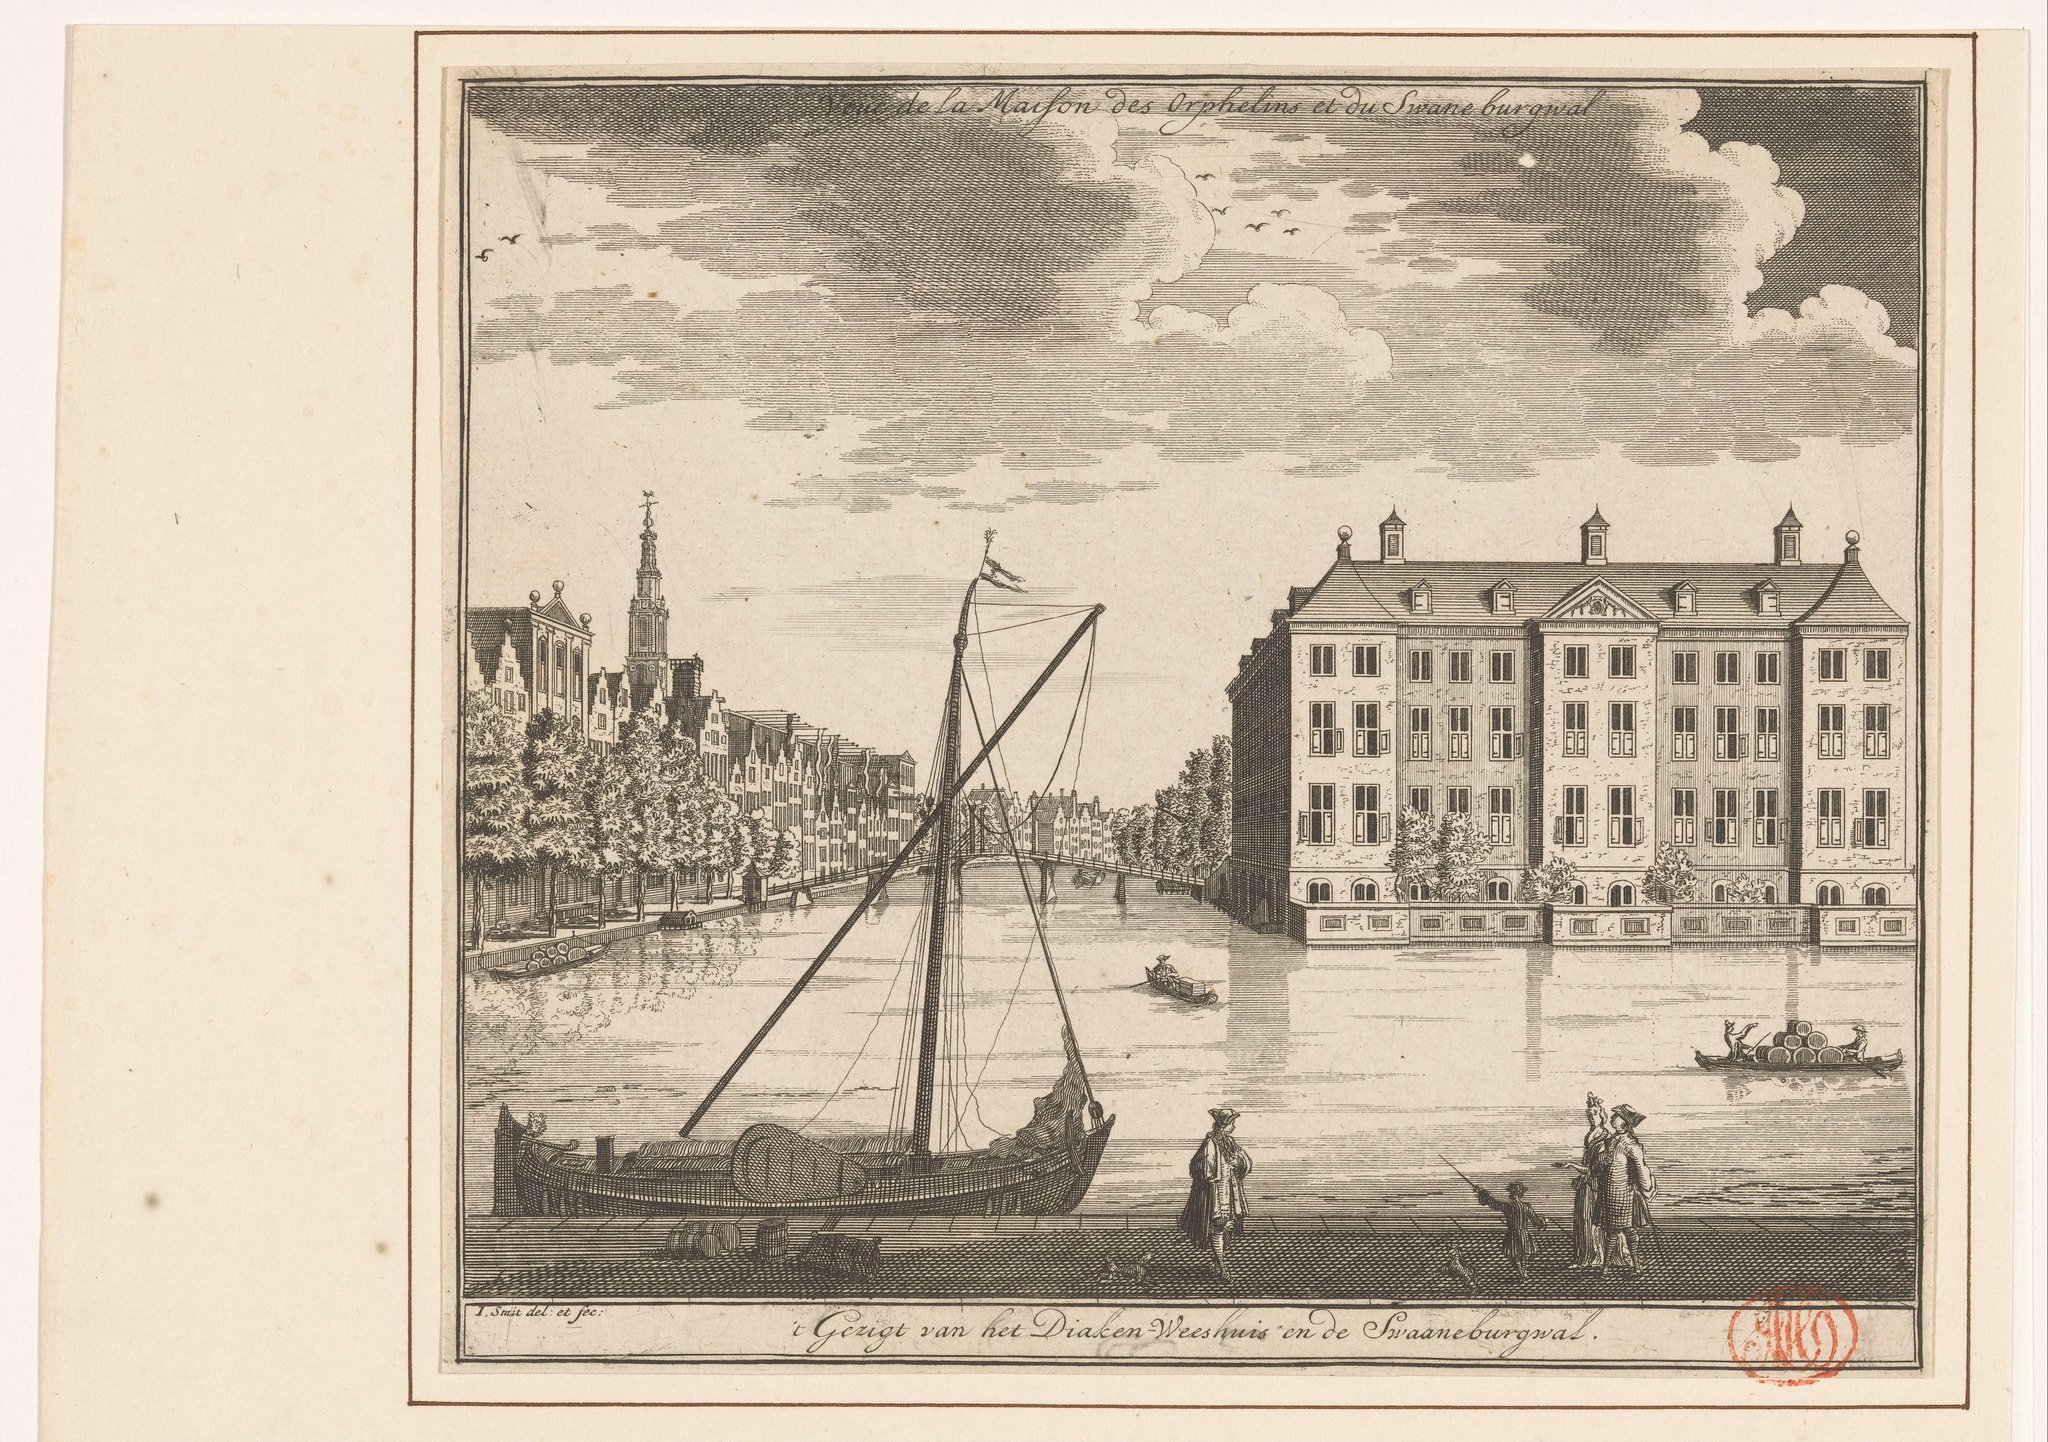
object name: print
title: Veüe de la Maison des Orphelins et du Swane burgwal / 't Gezigt van het Diaken-Weeshuis en de Swaaneburgwal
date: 1700-1748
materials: paper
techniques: engraving, etching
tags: bridge in city across river, canal, etc. (+ city(-scape) with figures, staffage), public welfare, orphanage, canals, waters (in city) (+ city(-scape) with figures, staffage)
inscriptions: collector's mark: Lugt 195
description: Tweede (of latere) staat van soortgelijke prenten van Jan Smit (o.a. RP-P-AO-26-38-3) ook gebruikt in: Le guide, ou nouvelle description d'Amsterdam; enseignant aux voyageurs, et aux negocians (…) Avec une description de sa belle Maison de Ville (…). Amsterdam: Covens & Mortier & Covens Jr., 1772.